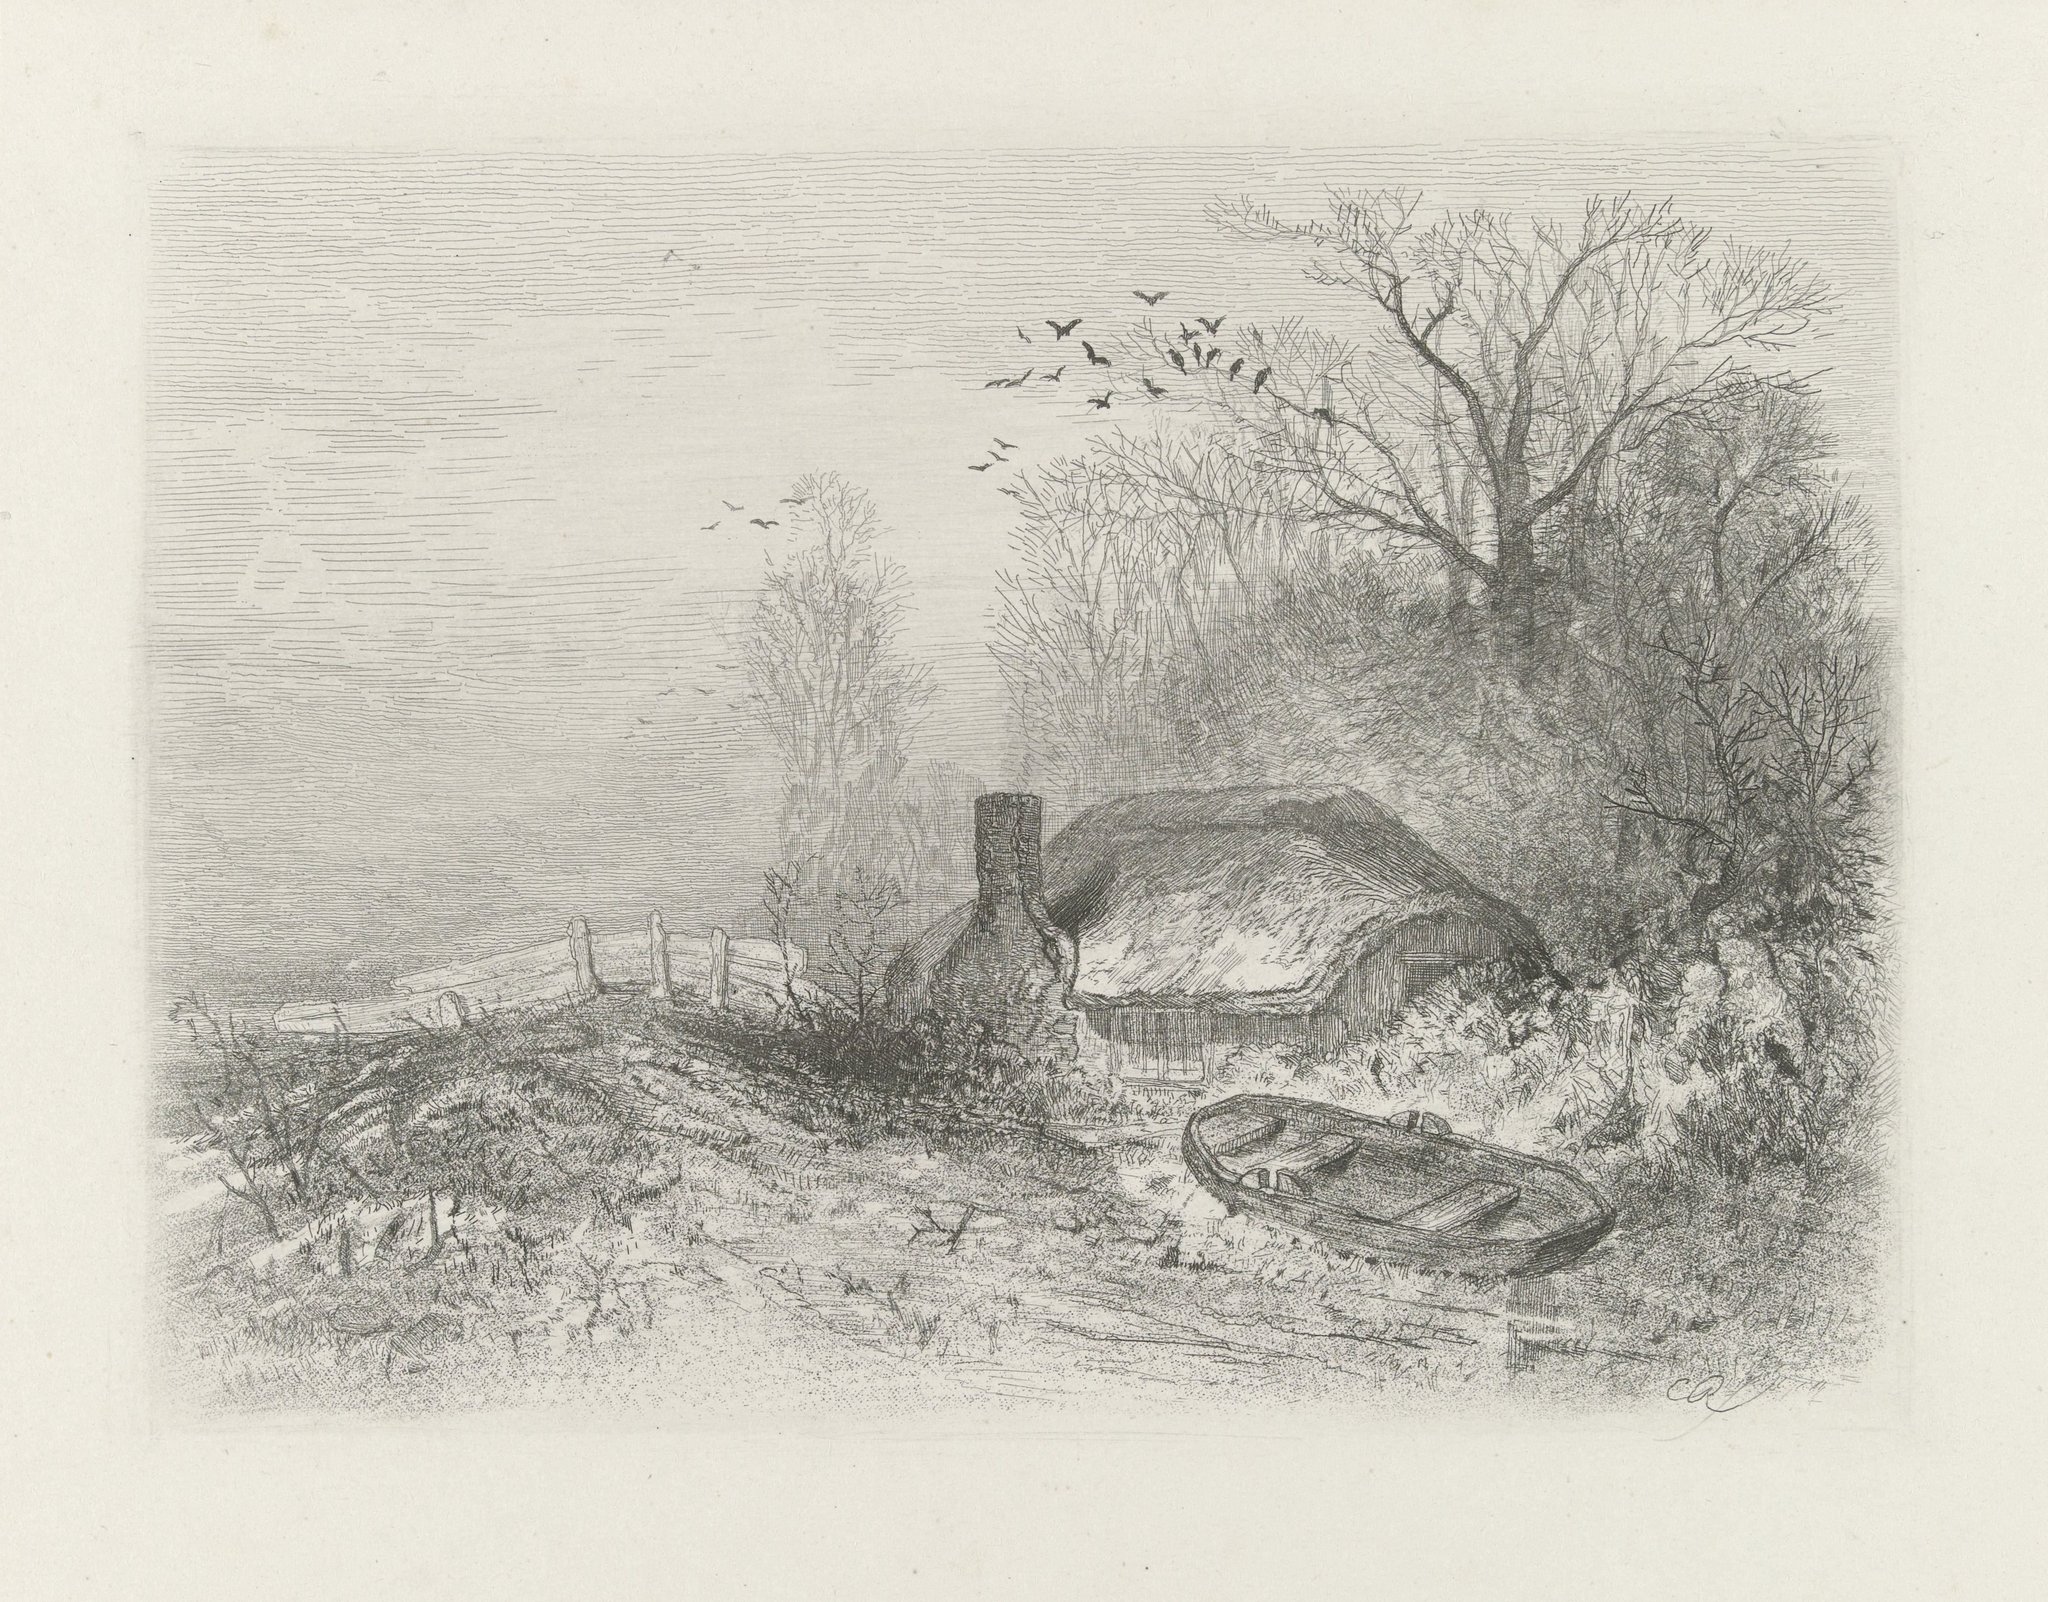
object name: print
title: Hut in een landschap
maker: charles rochussen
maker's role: draughtsman, painter, print maker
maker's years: 1814-1894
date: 1824-1894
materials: paper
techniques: etching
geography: netherlands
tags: rowing-boat, canoe, etc., farm or solitary house in landscape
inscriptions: collector's mark: Lugt 2228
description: Glooiend landschap met een hut en een boot. Boven de hut een groep vogels.